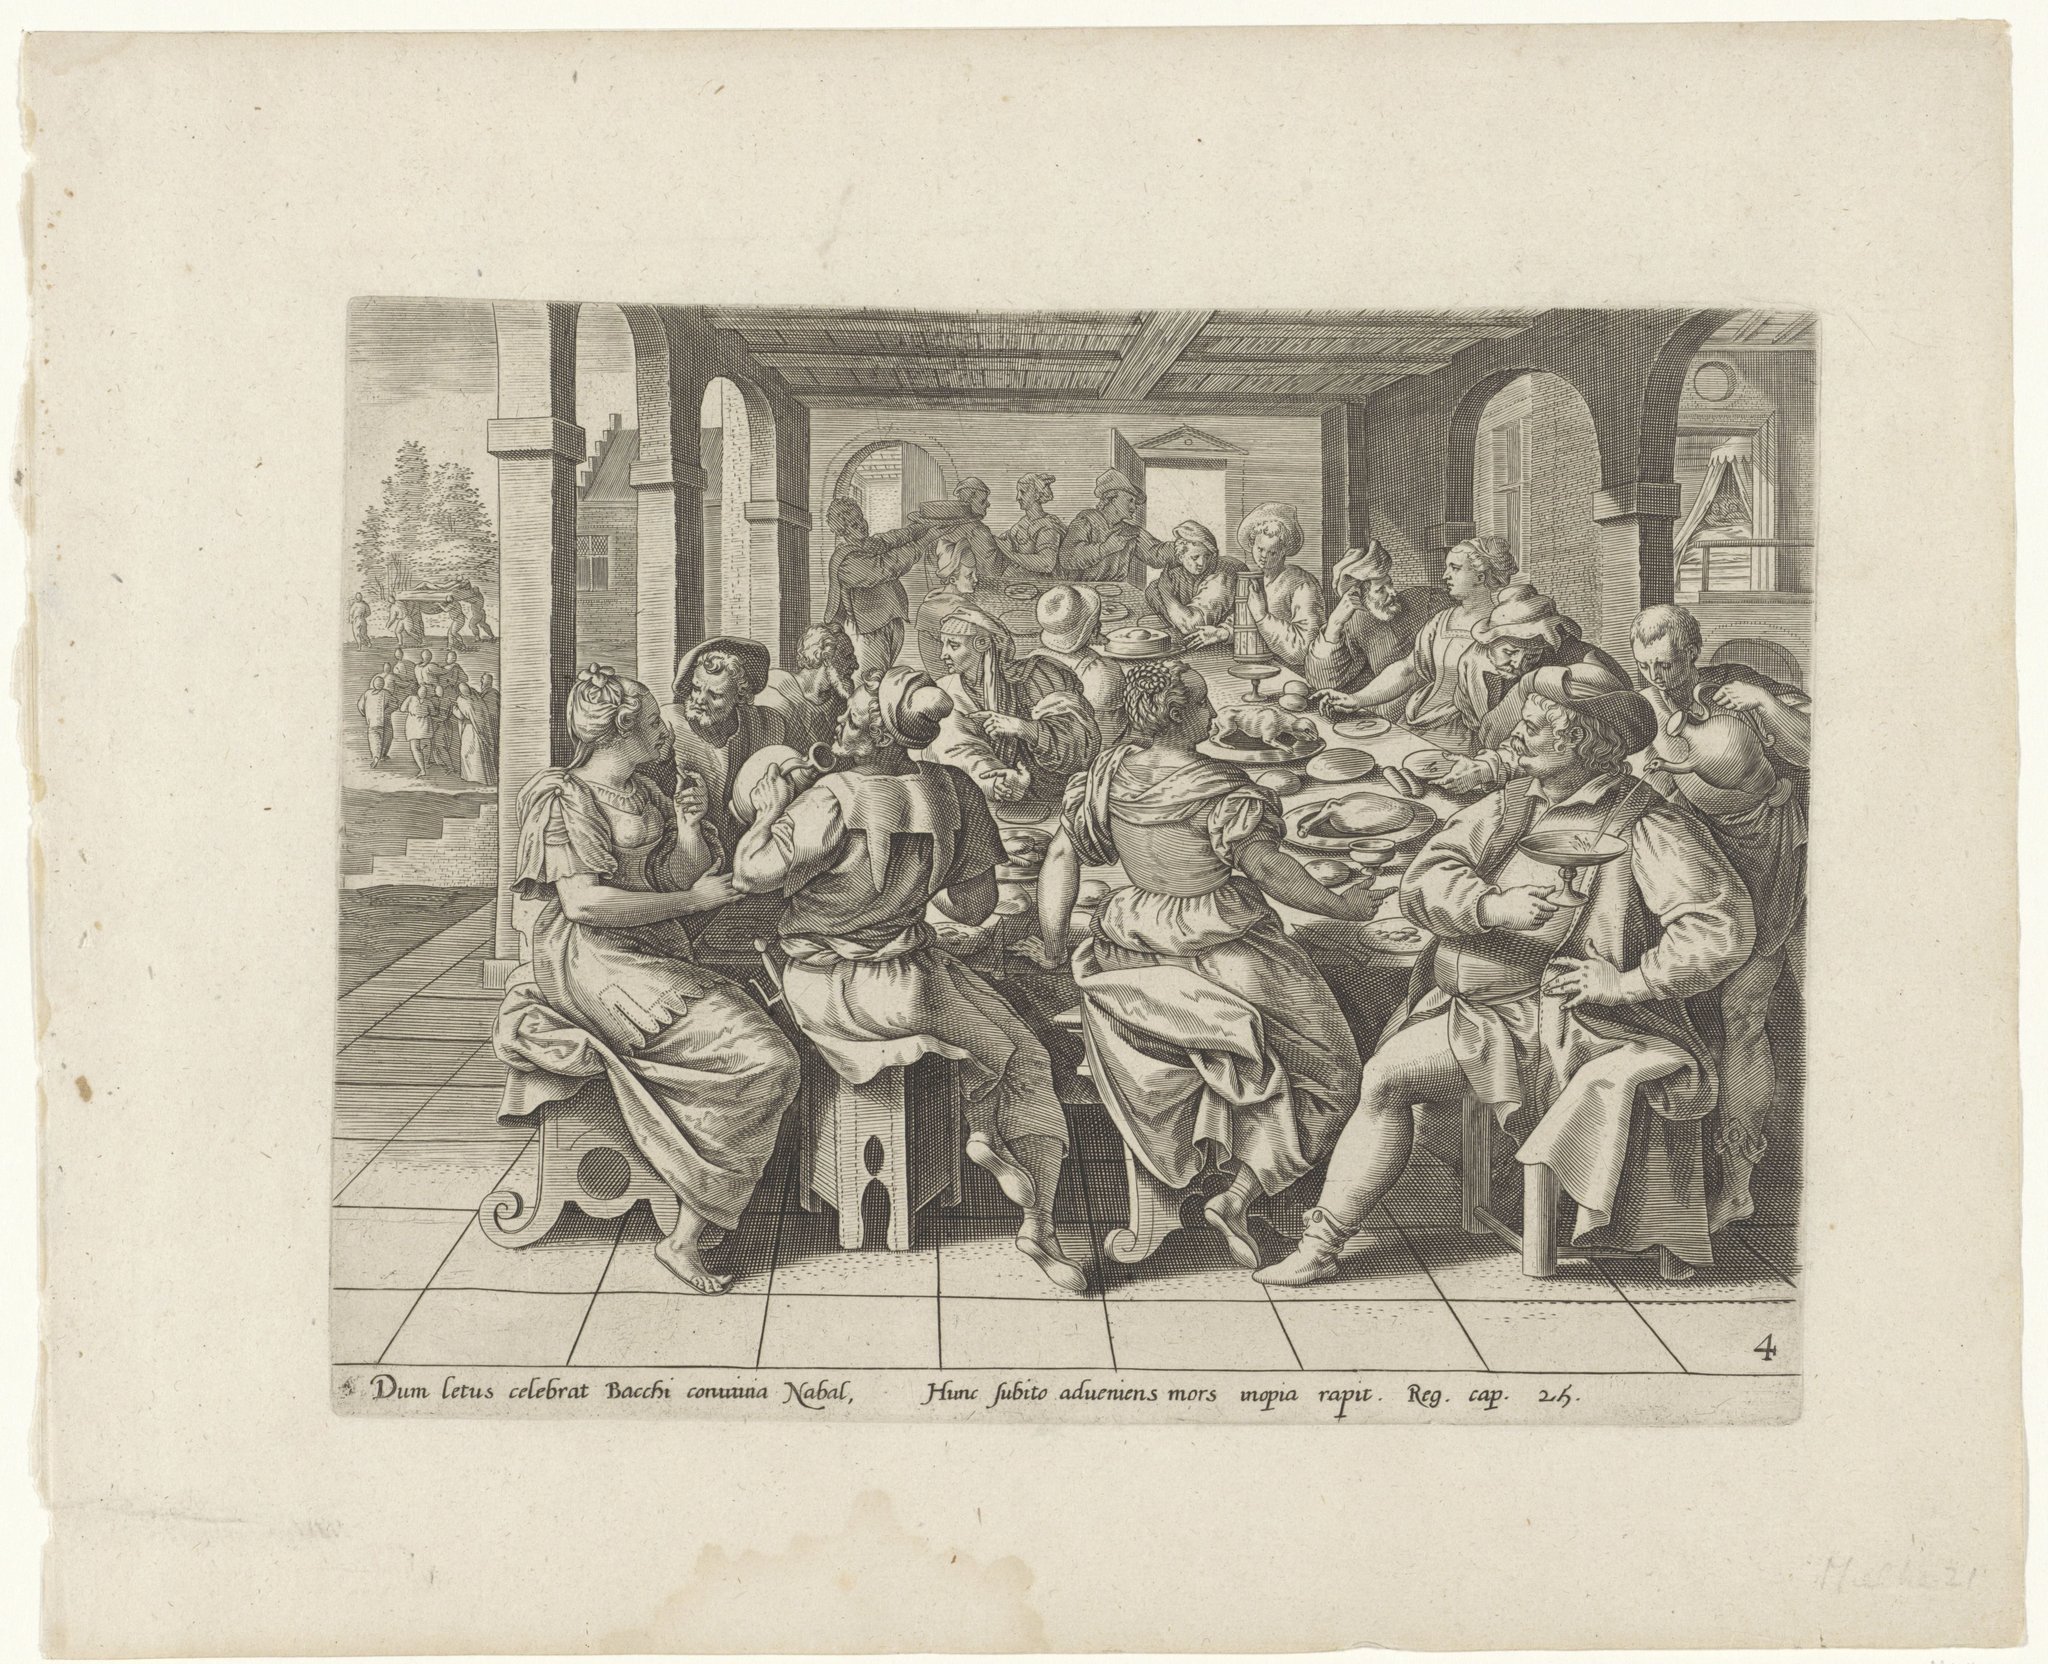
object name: print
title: Feest van Nabal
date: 1585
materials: paper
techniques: engraving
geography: antwerp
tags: nabal dies, the banquet in nabal's house, celebration meal, feast, banquet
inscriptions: collector's mark: Lugt 2228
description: Nabal en Abigaïl zitten aan Nabals feestmaal en Nabal laat zich nog eens inschenken. Rechts op de achtergrond het bed van Nabal en Abigaïl. Nadat Nabal zijn roes had uitgeslapen vertelde Abigaïl wat ze had gedaan. Op die mededeling stierf Nabal. Links op de achtergrond de rouwstoet, waarmee het lichaam van Nabal wordt weggedragen. Onder de voorstelling een verwijzing in het Latijn naar de Bijbeltekst in 1 Sam. 25.